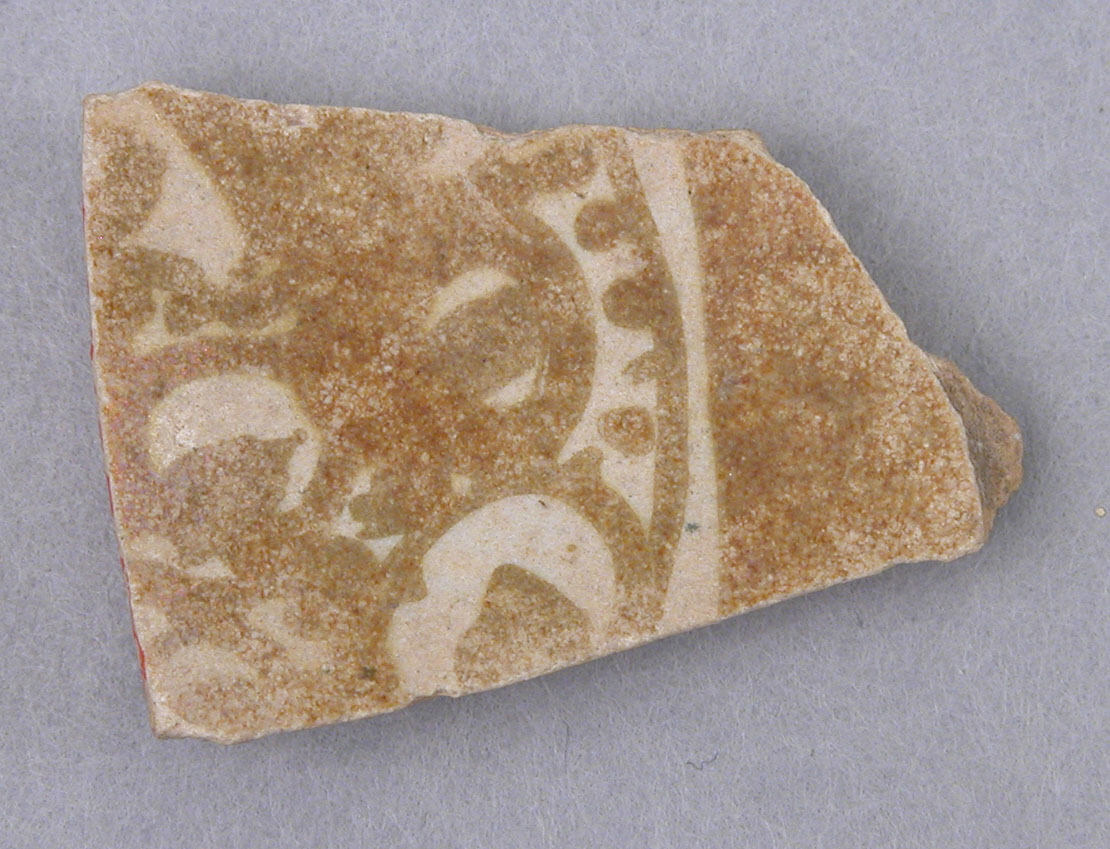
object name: fragment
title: Fragment of a Luster-Painted Open Vessel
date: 801-1000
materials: earthenware, glaze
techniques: luster painting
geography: iraq